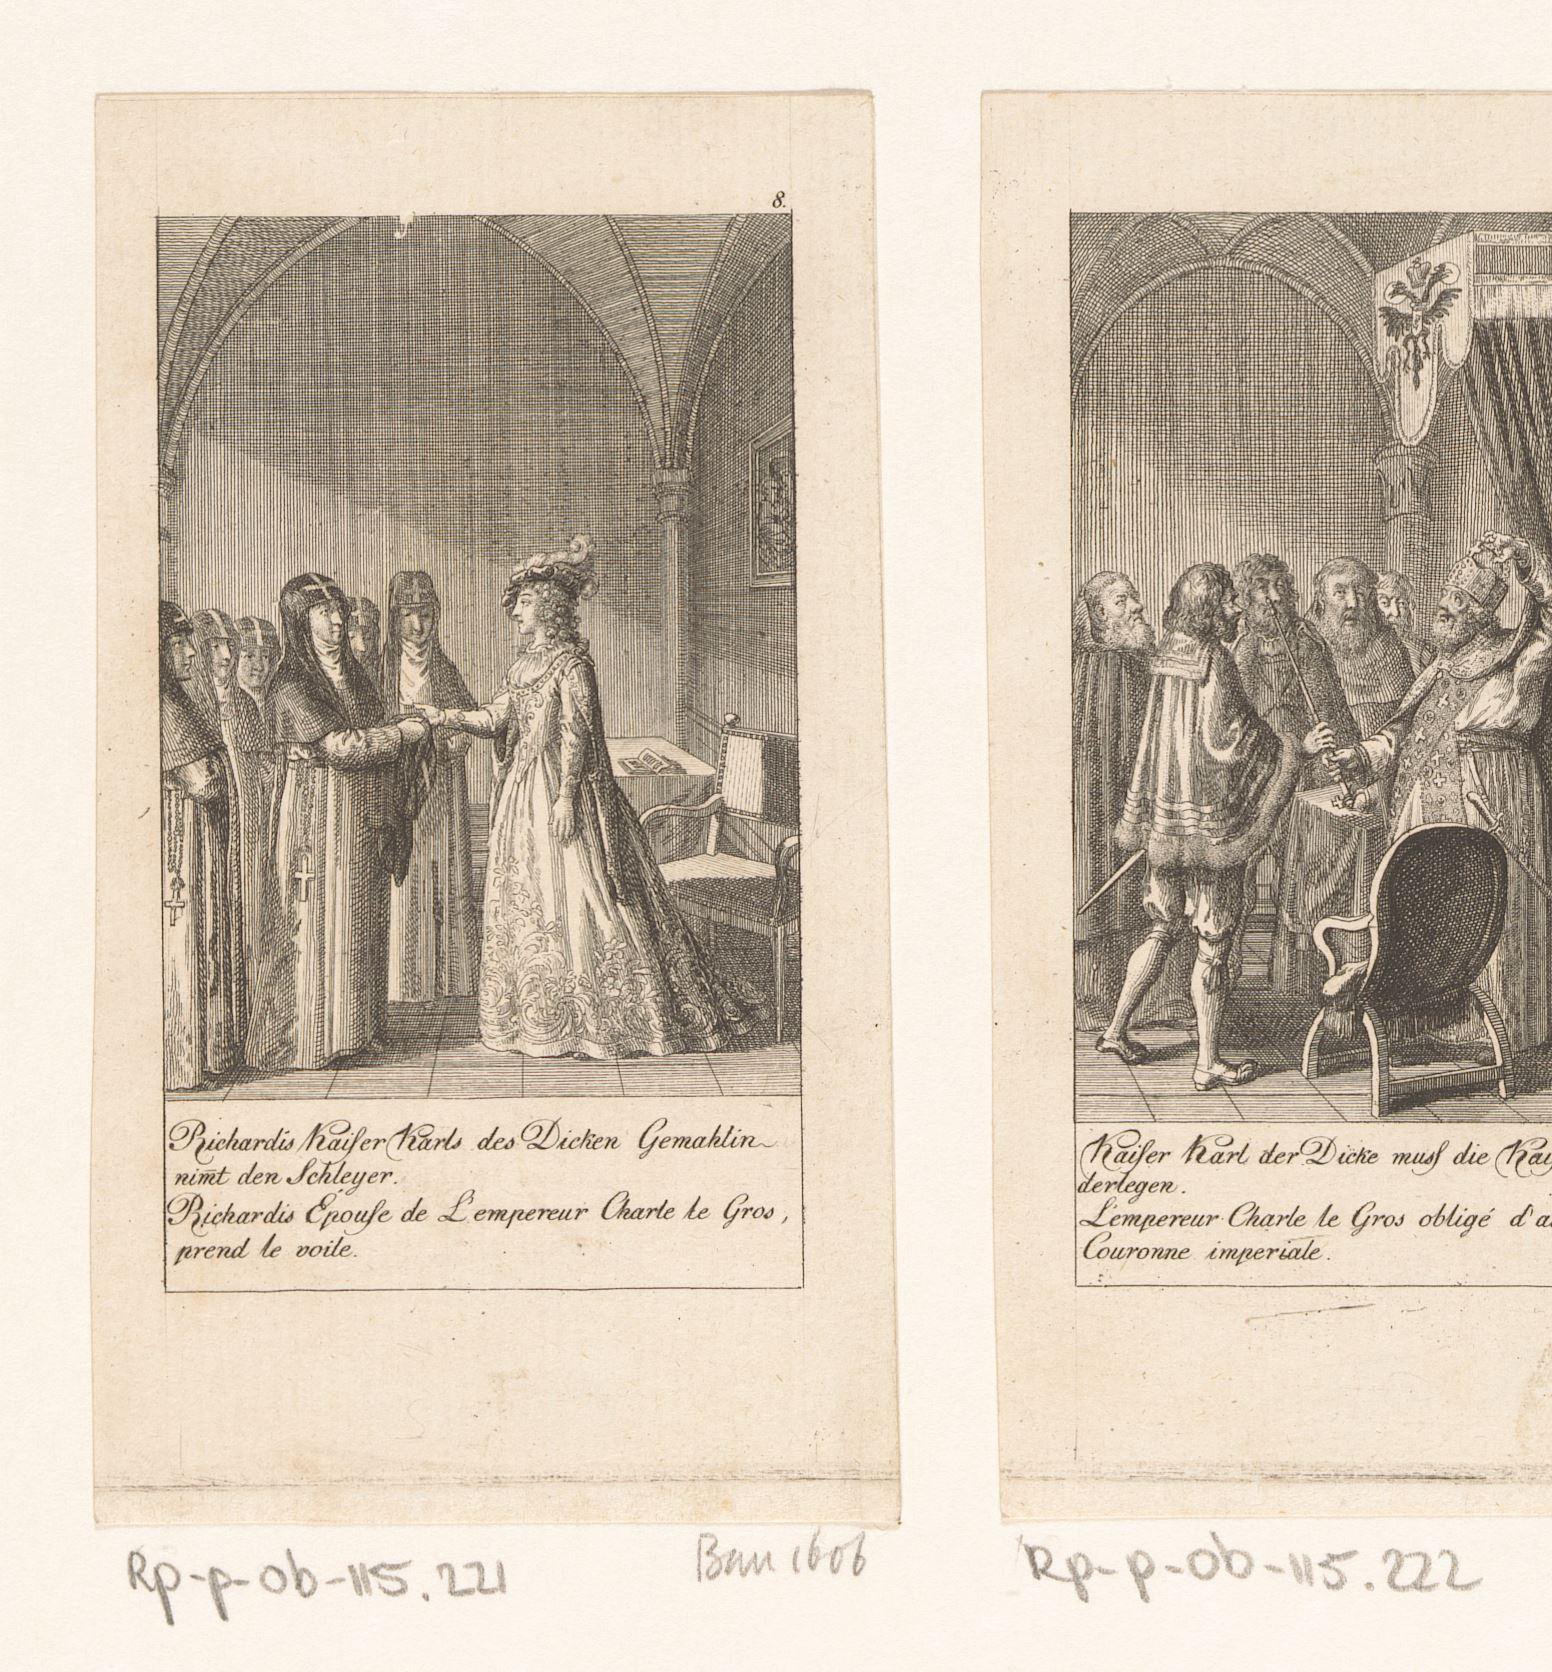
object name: print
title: Richarda in het klooster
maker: daniel nikolaus chodowiecki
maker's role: draughtsman, print maker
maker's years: 1726-1801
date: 1792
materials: paper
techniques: etching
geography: berlin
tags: history, nun(s), ruler, sovereign - bb - female ruler, cloisters ~ monastery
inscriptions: collector's mark: Lugt 2228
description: Latere staat gebruikt voor: Almanac de Gotha pour l'anneé 1793. Gotha: C. W. Ettinger, [1792].